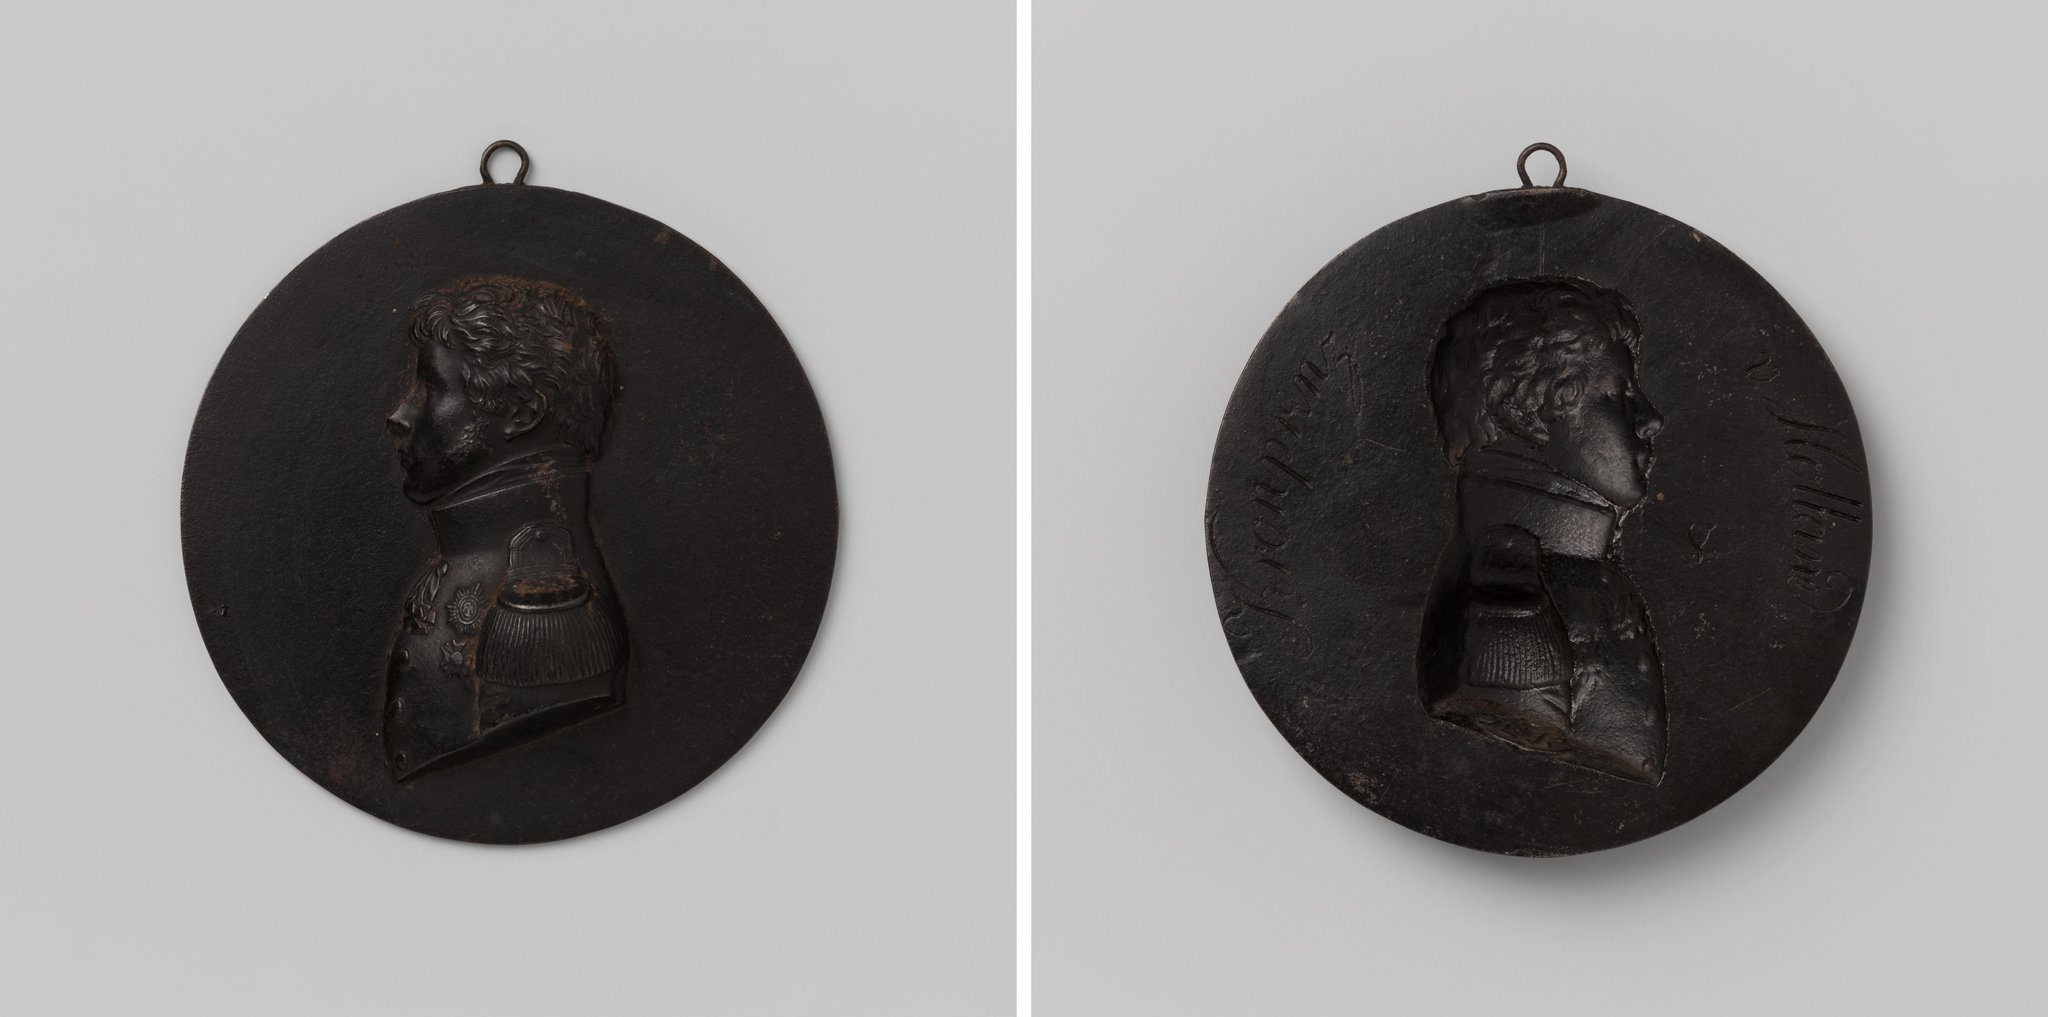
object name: plaque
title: Willem Frederik George Lodewijk, erfprins der Nederlanden [?]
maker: leonhard posch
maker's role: sculptor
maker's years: 1750-1831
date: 1816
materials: iron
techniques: casting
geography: berlin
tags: the hague, william ii of the netherlands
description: plaquette aan draagoog. Voorzijde: borststuk man naar links. Keerzijde: opschrift: "Kronprinz v. Holland"; in negatief van borststuk: signatuur [?] .L